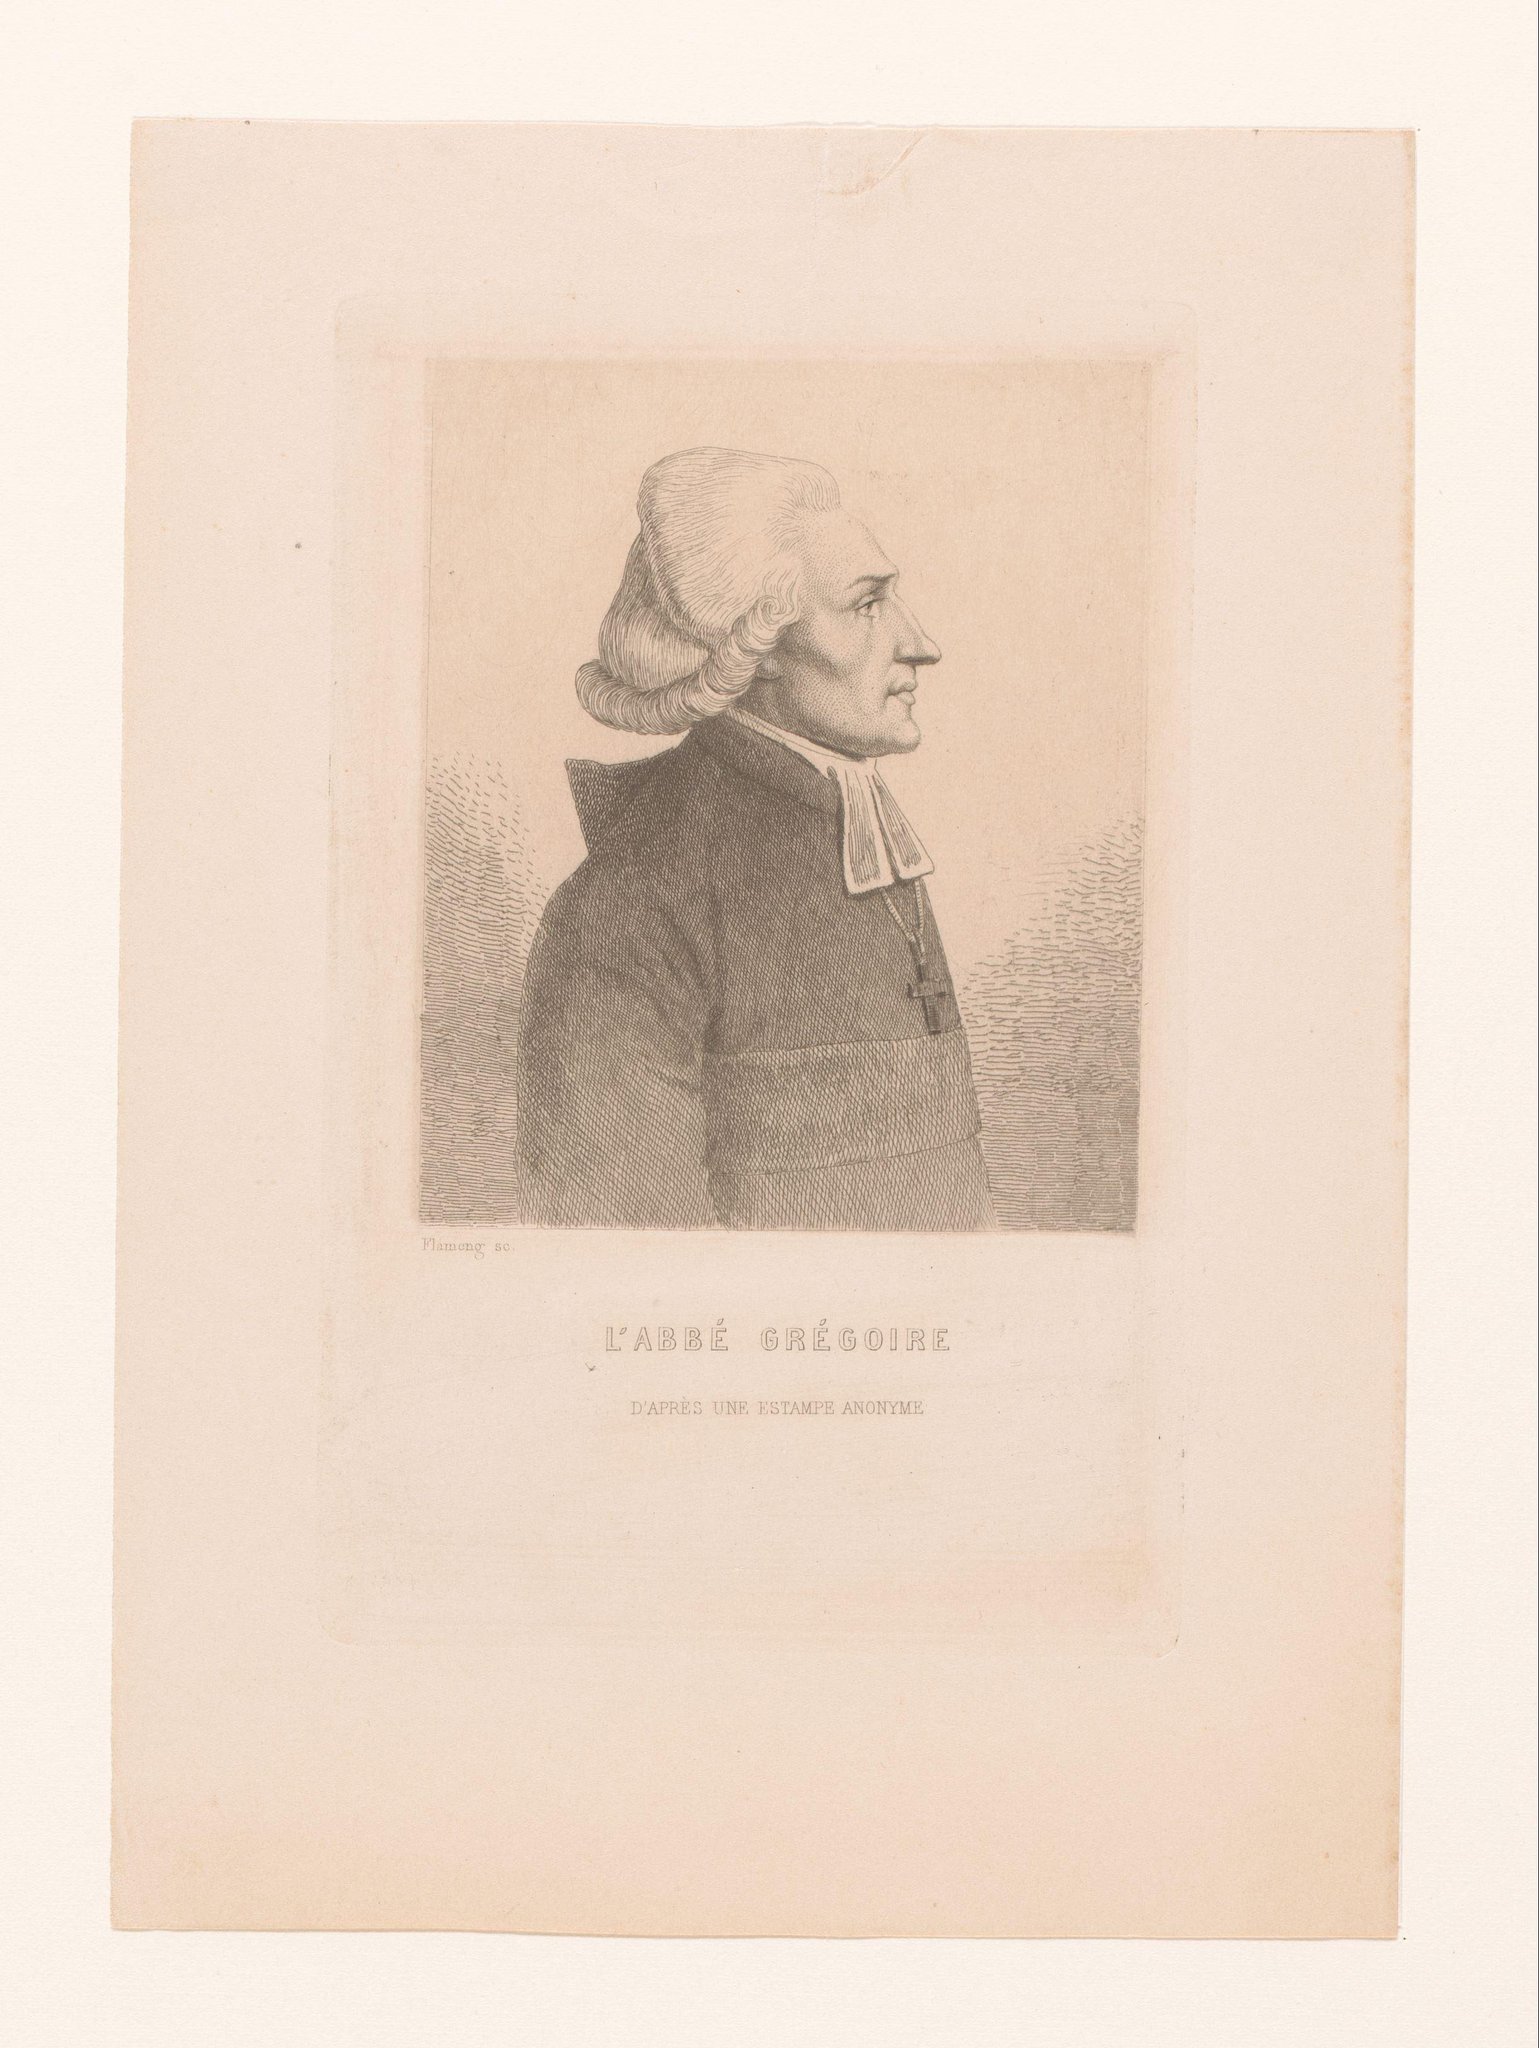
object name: print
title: L'abbé Grégoire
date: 1841-1910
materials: paper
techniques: etching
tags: priest, historical persons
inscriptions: collector's mark: Lugt 2228